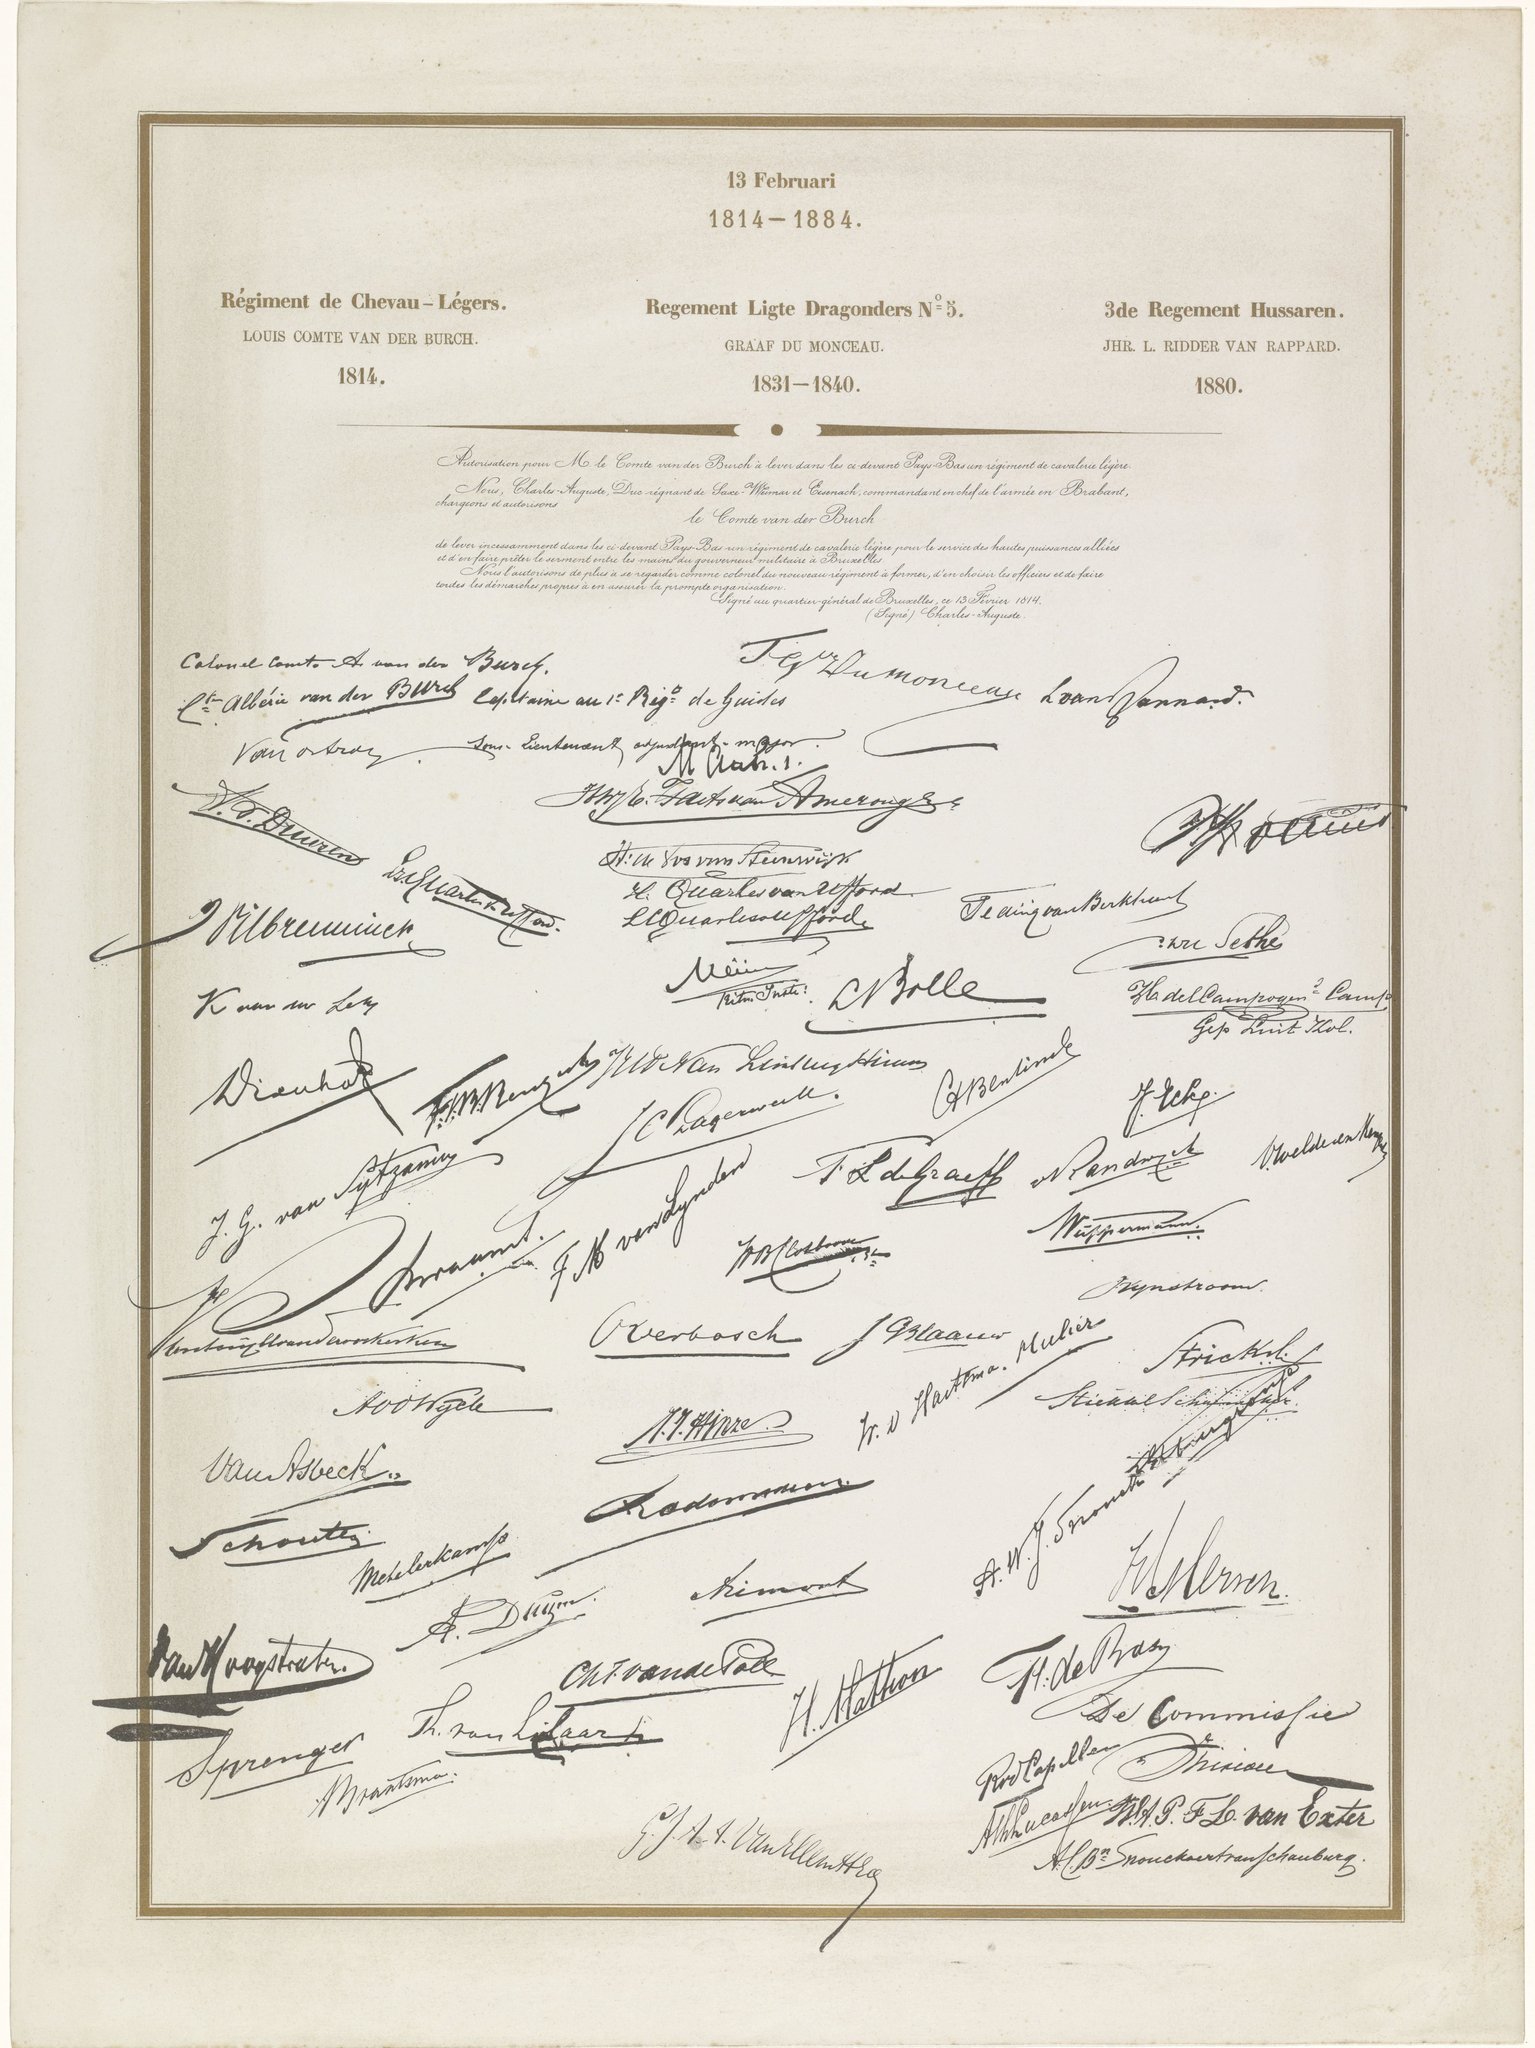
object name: print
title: Portret van Willem I koning van Württemberg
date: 1823-1895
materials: paper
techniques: aquatint, etching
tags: willem i koning van württemberg, historical persons, king